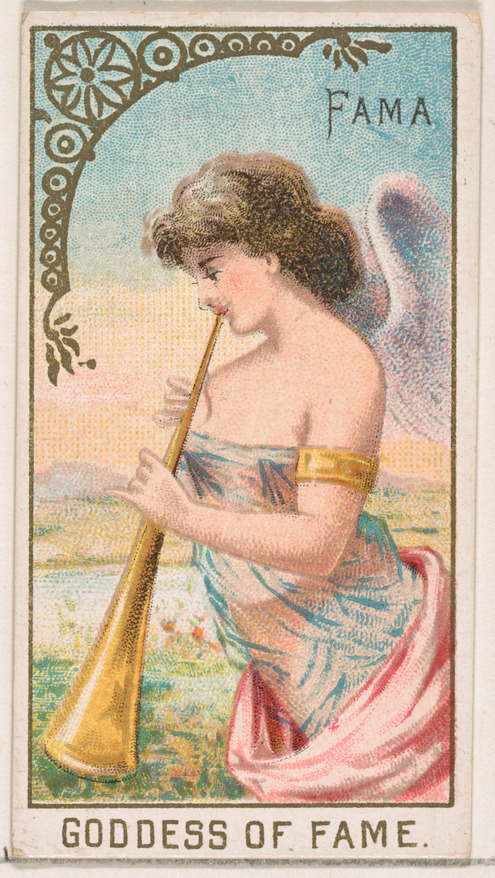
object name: print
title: Fama, Goddess of Fame, from the Goddesses of the Greeks and Romans series (N188) issued by Wm. S. Kimball & Co.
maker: william s. kimball & company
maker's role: publisher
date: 1889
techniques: color lithograph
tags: musical instruments,women,goddess